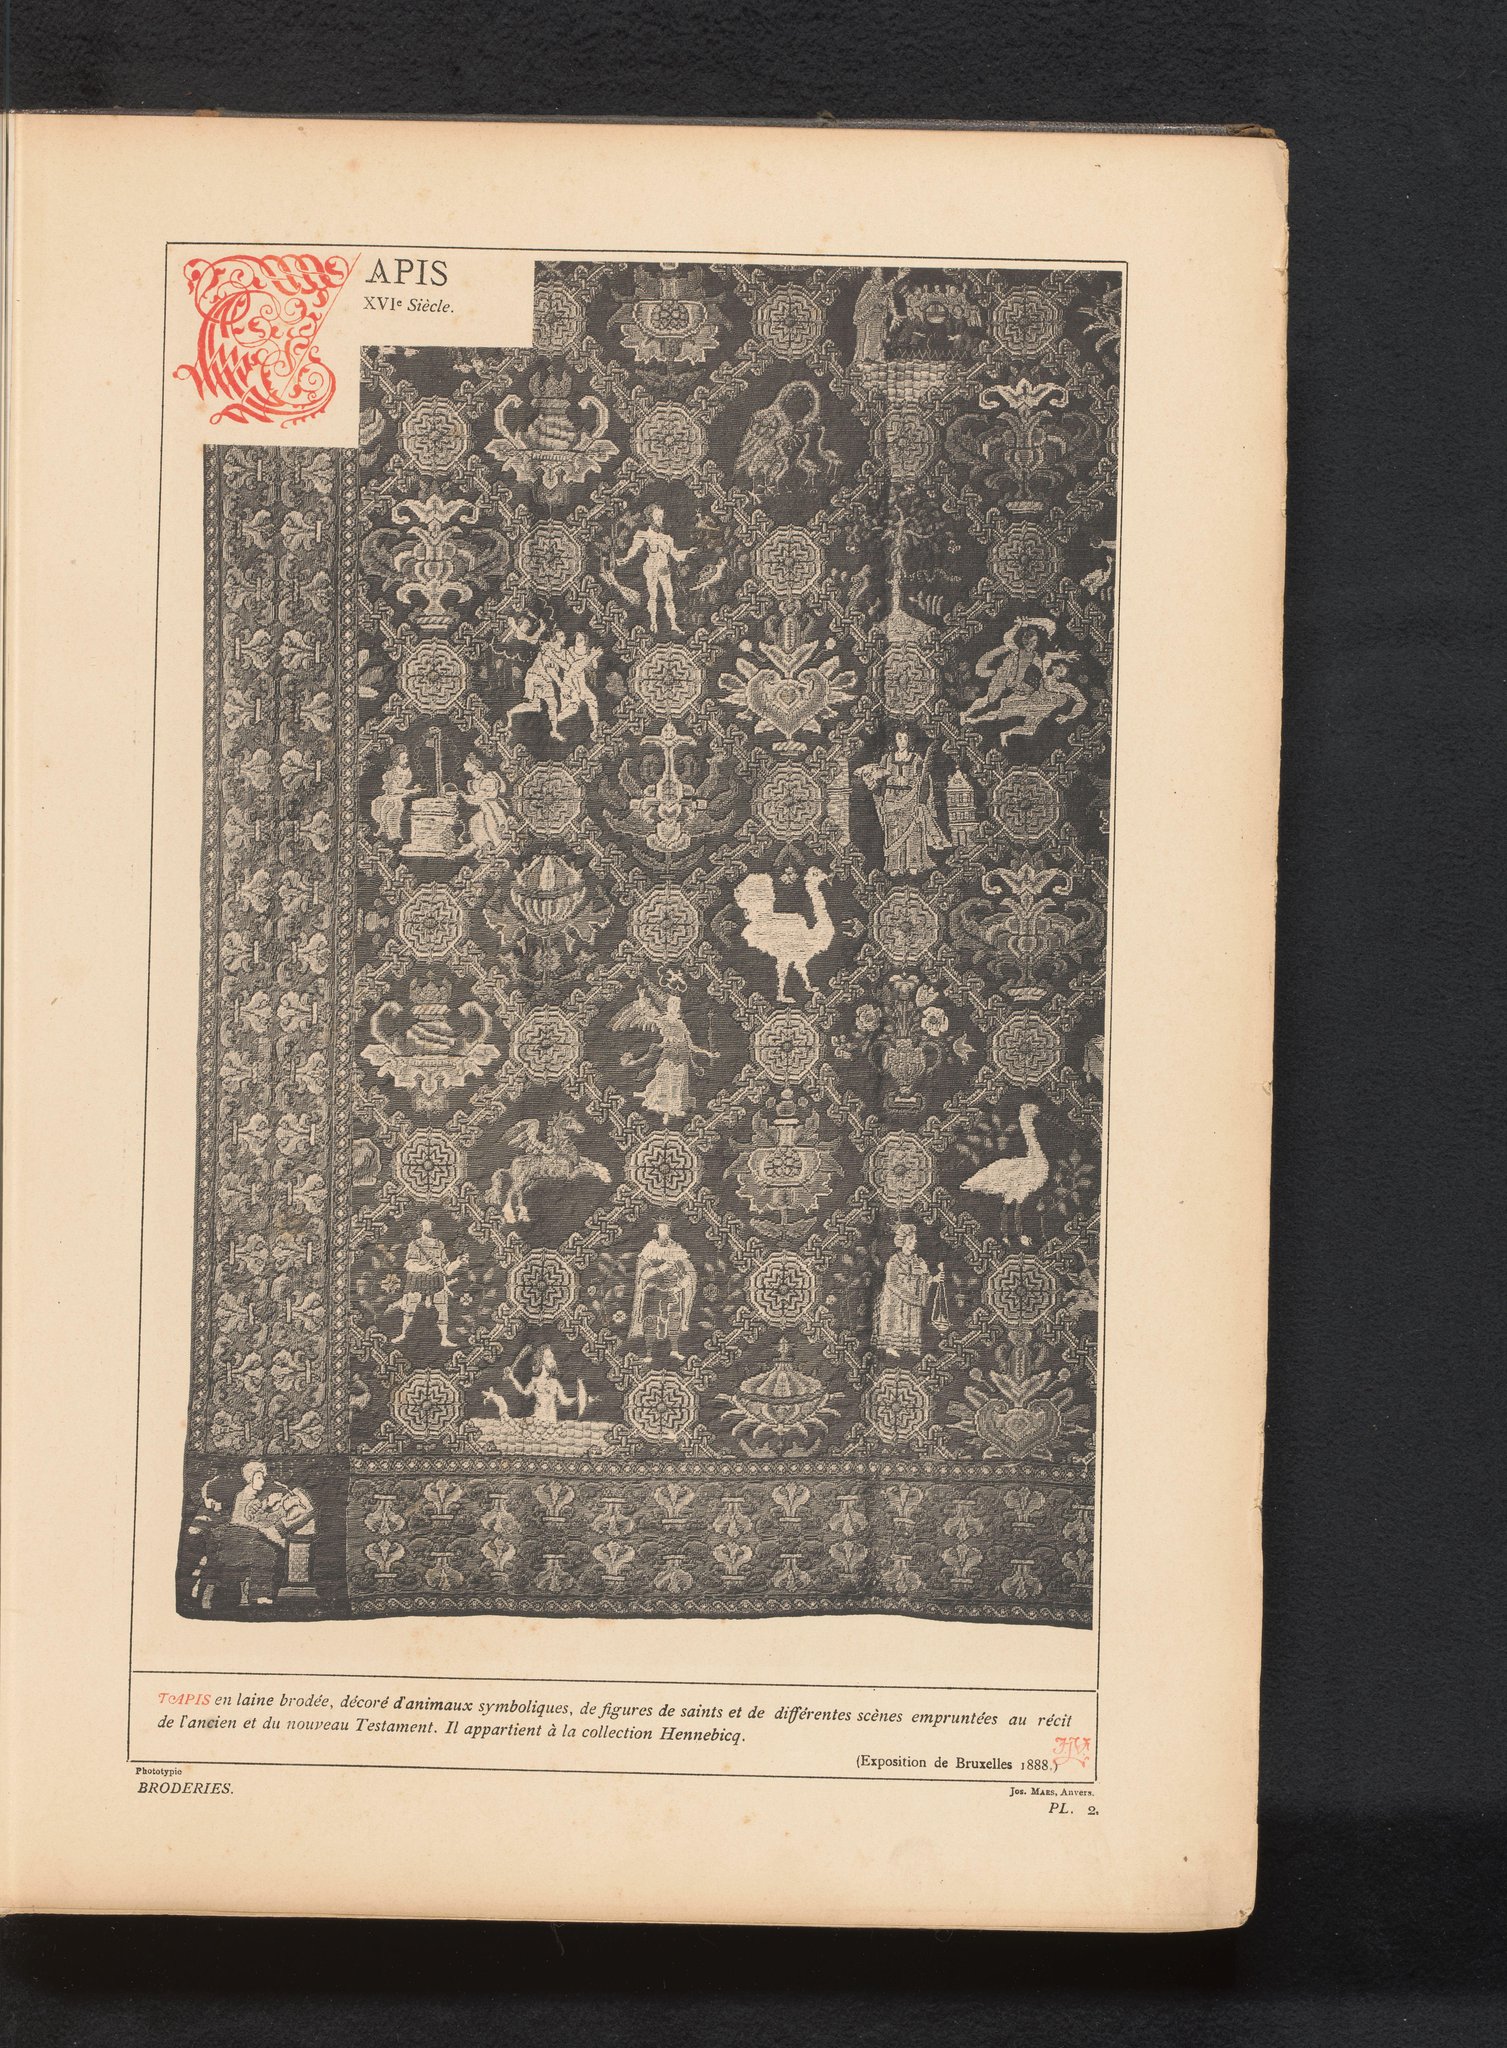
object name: photomechanical print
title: Tapijt met daarop heiligen en scènes uit het Nieuwe Testament geborduurd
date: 1881-1889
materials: paper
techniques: photograph, photolithography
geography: antwerp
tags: new testament, embroidery (ornamentation)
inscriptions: monogram: ‘JJvY’, inscription: ‘TAPIS en laine (...)’, inscription: ‘BRODERIE. PL.2.’